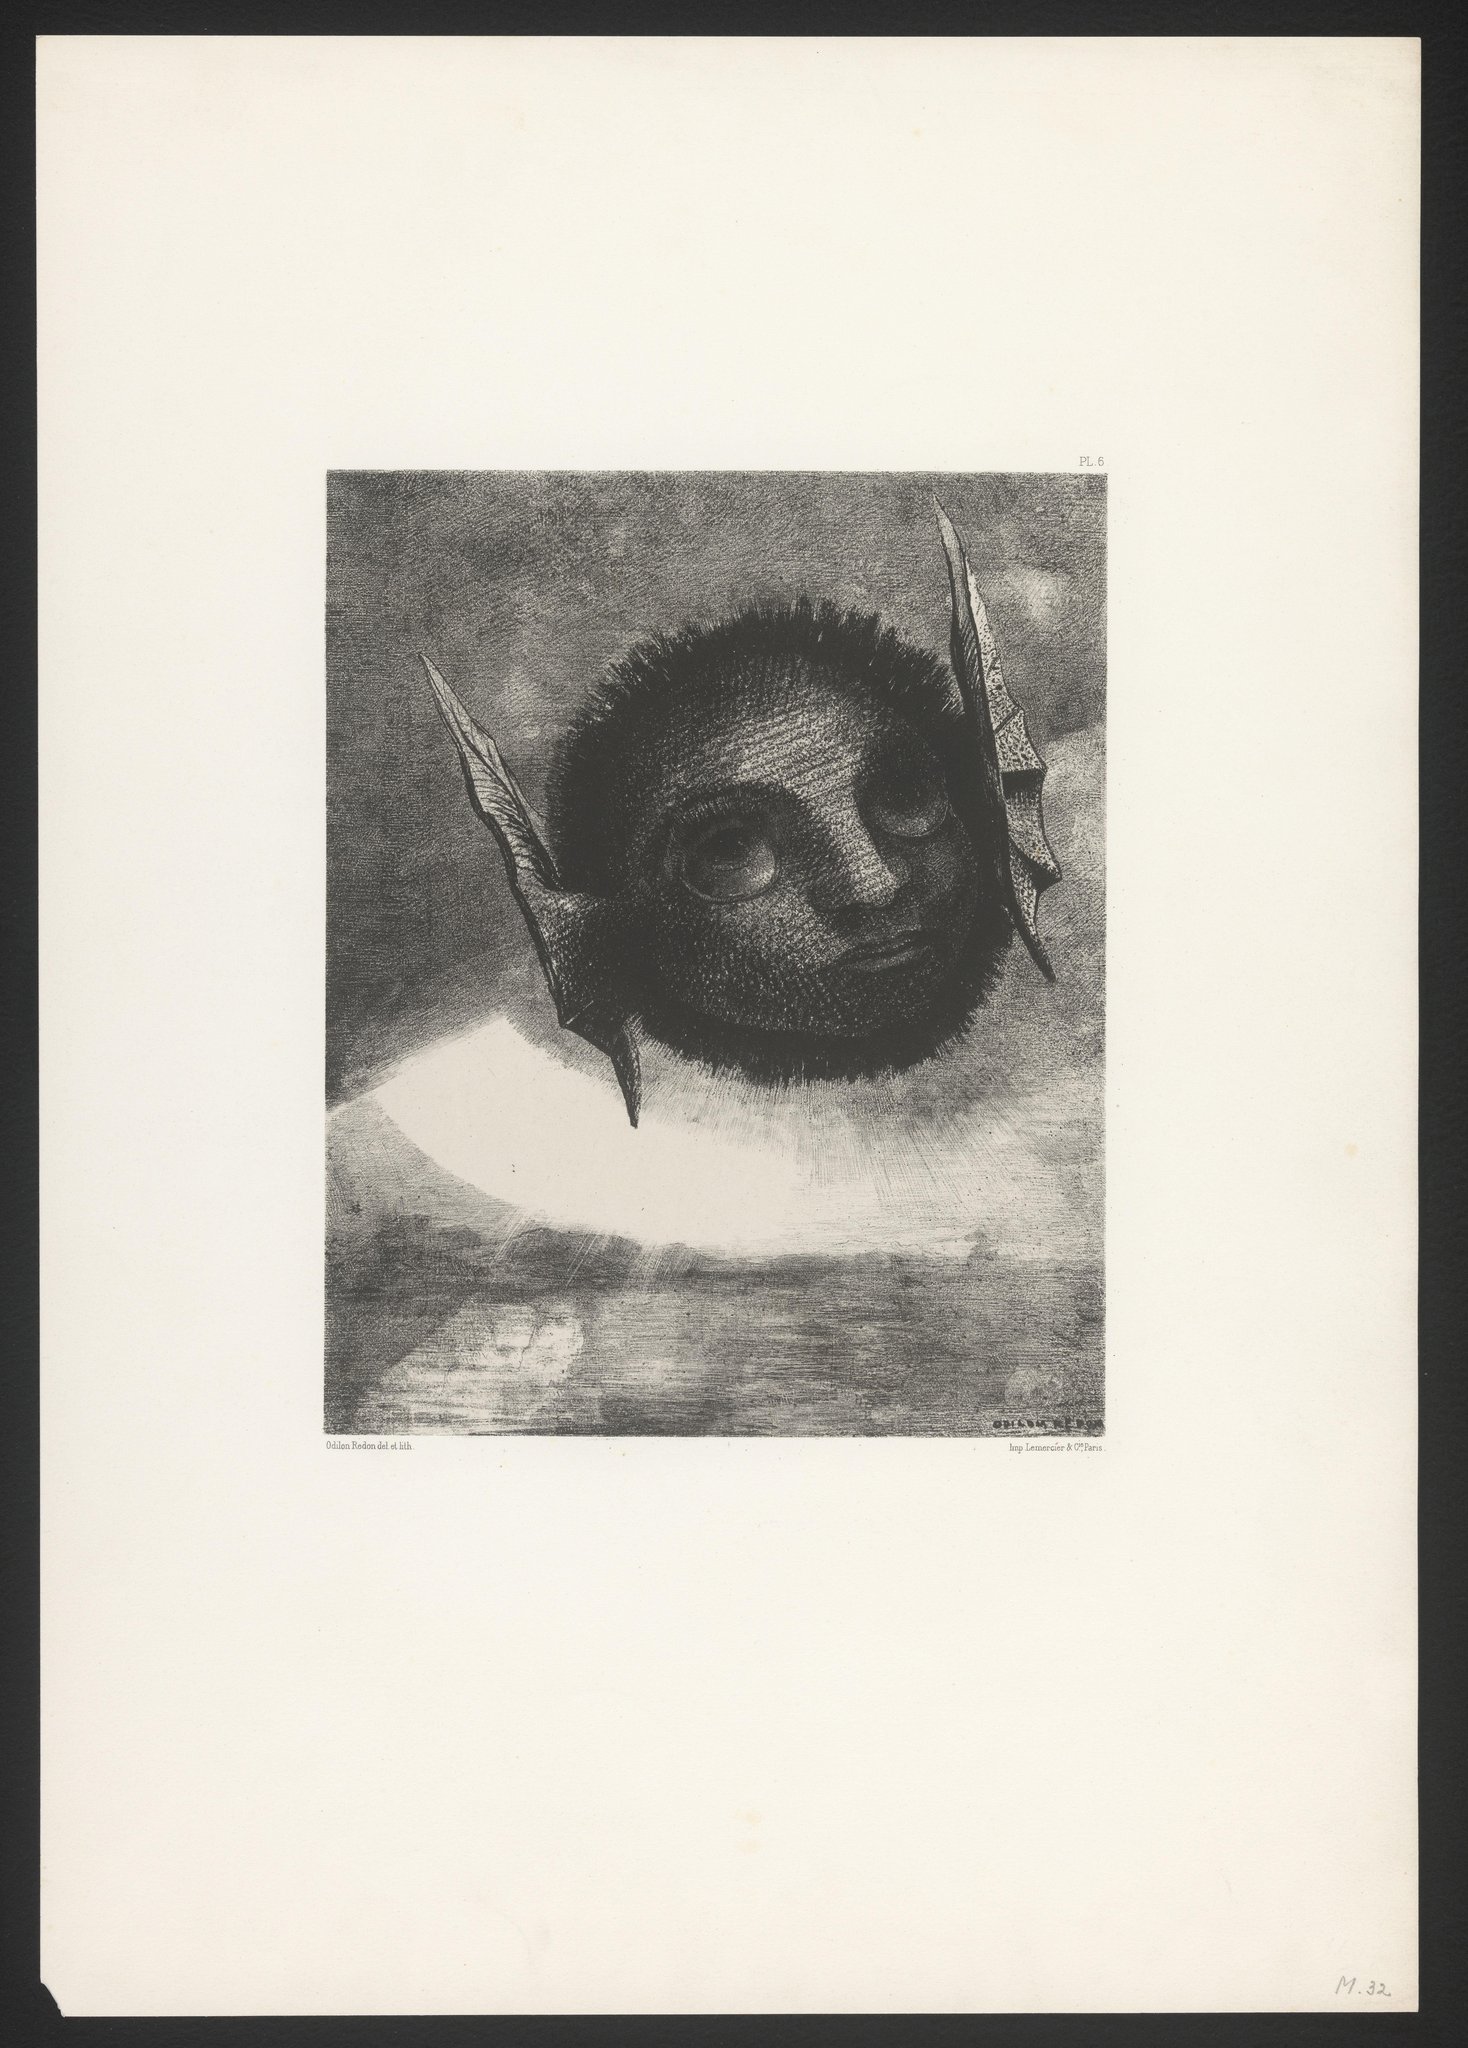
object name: print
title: In de droom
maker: odilon redon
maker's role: draughtsman, painter, print maker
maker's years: 1840-1916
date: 1879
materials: paper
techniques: lithograph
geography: paris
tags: face, flying mammals: bat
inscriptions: collector's mark: Lugt 2760, collector's mark: Lugt 2228